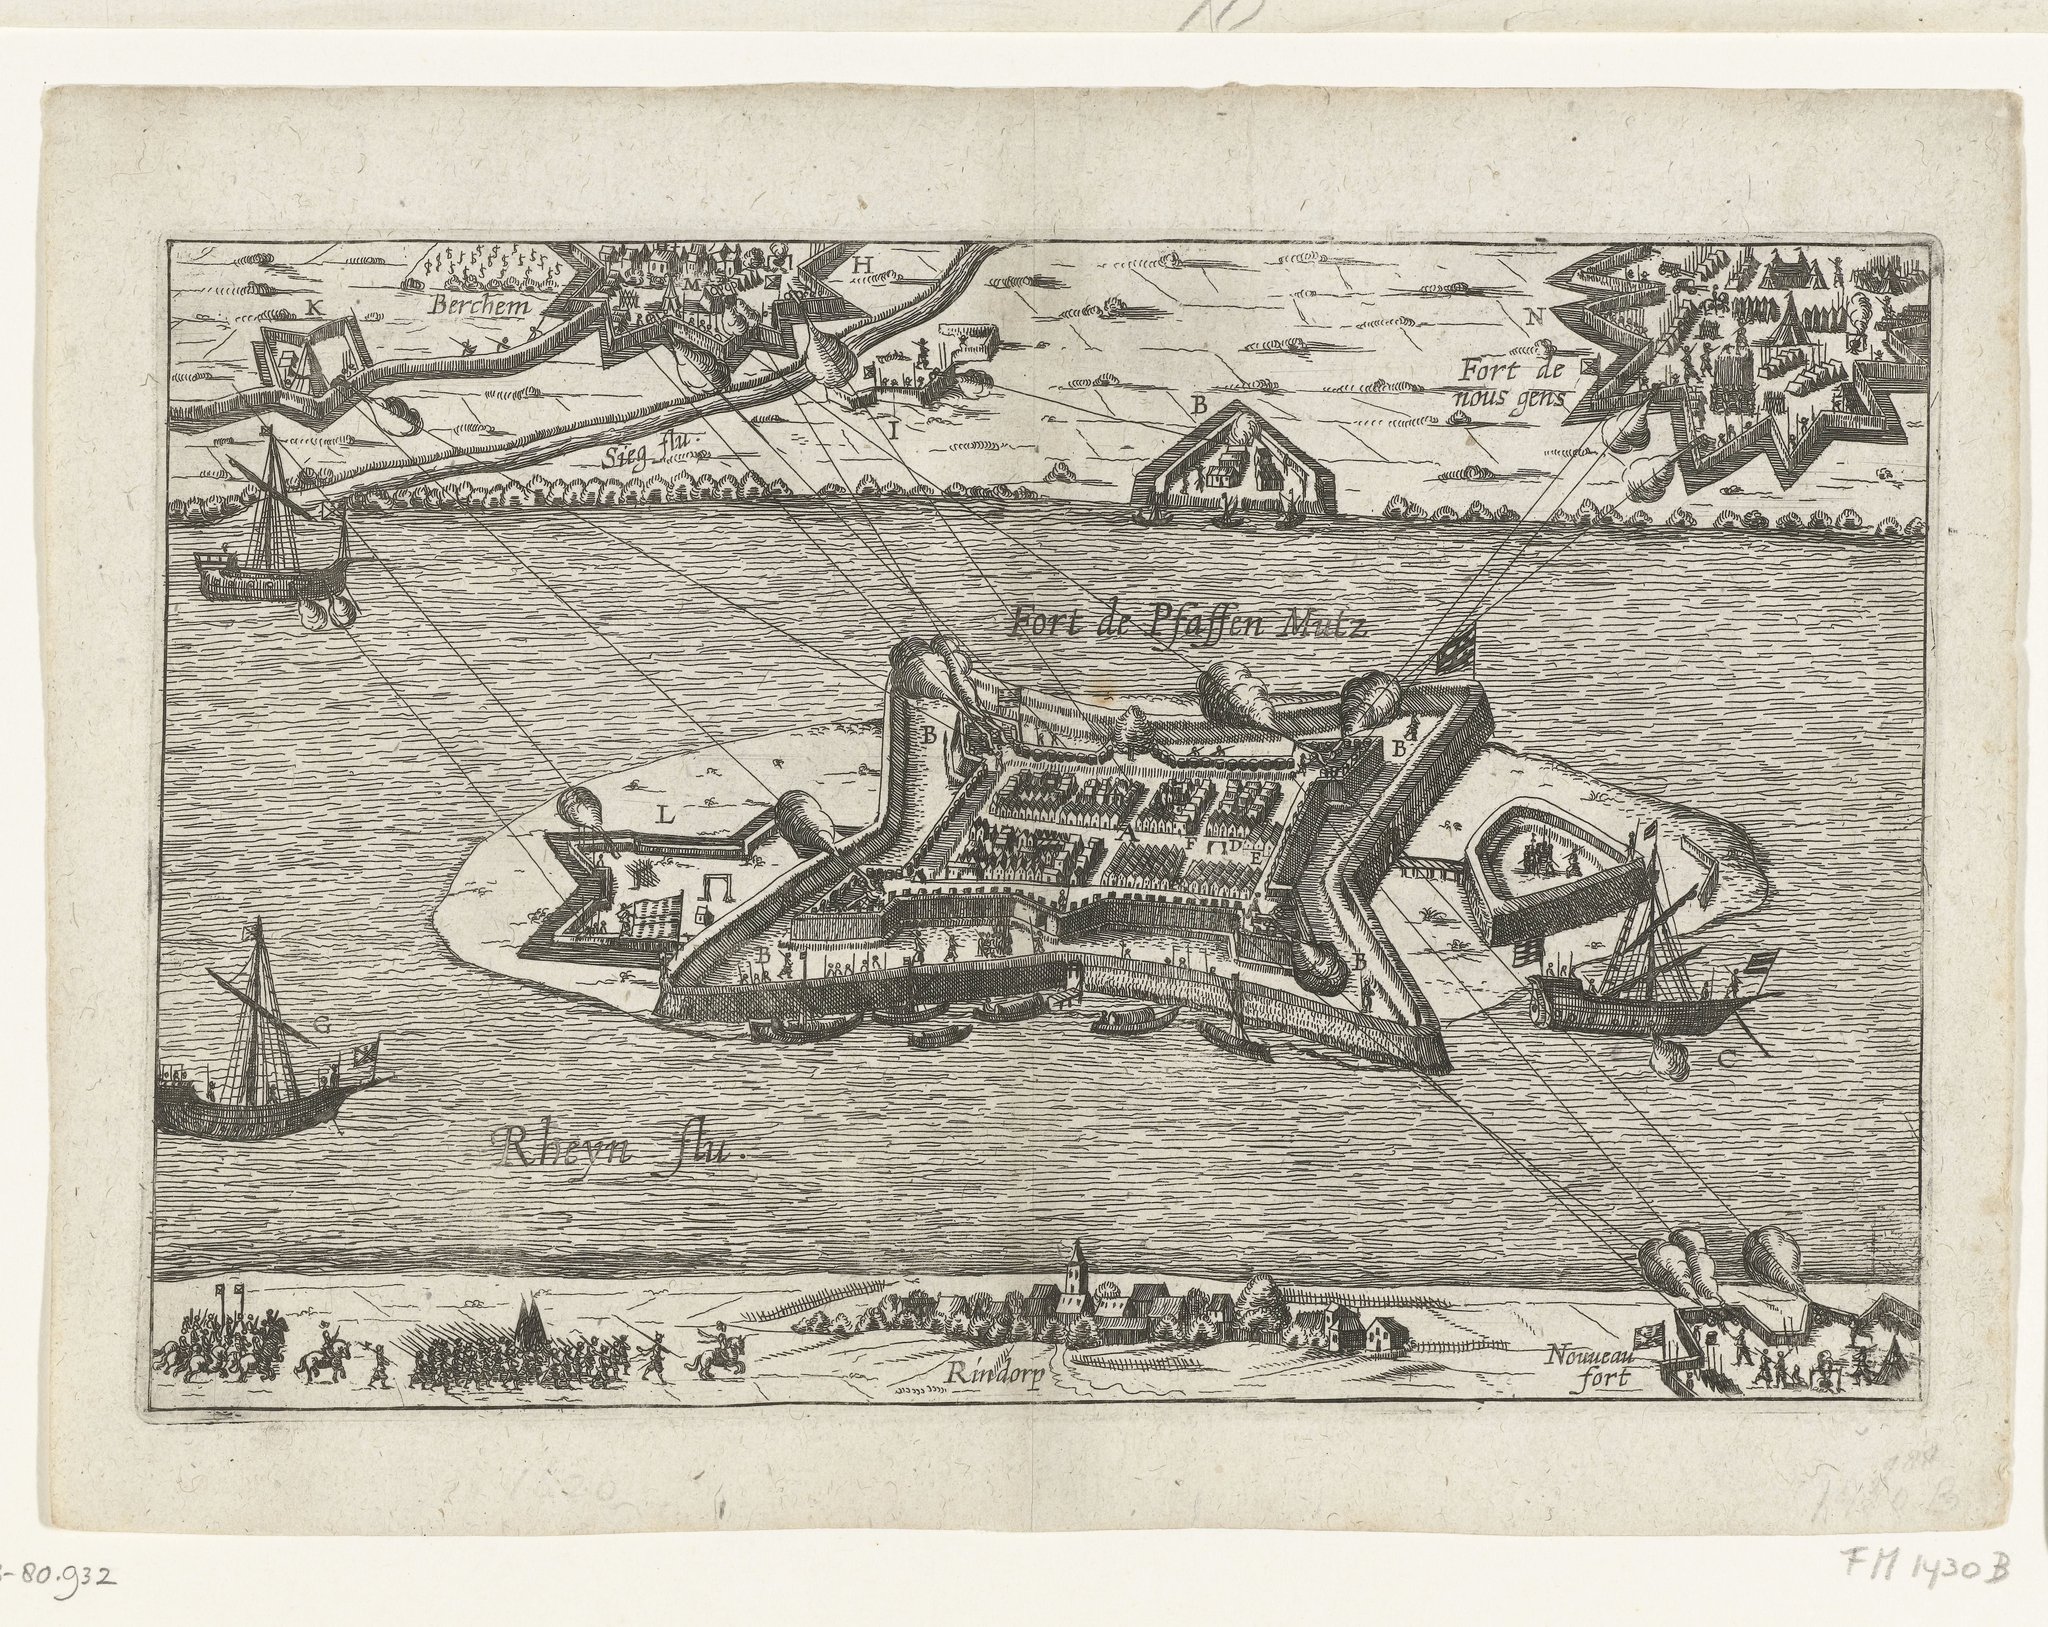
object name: print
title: Beschietingen van en vanuit de schans Papenmuts gebouwd door Maurits in de Rijn, 1620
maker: Anonymous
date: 1620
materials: paper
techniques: etching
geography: germany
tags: maurice (prince of orange), fortifications, military engineering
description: Beschietingen van en vanuit de schans Papenmuts gebouwd door prins Maurits in de Rijn, 6 oktober 1620.